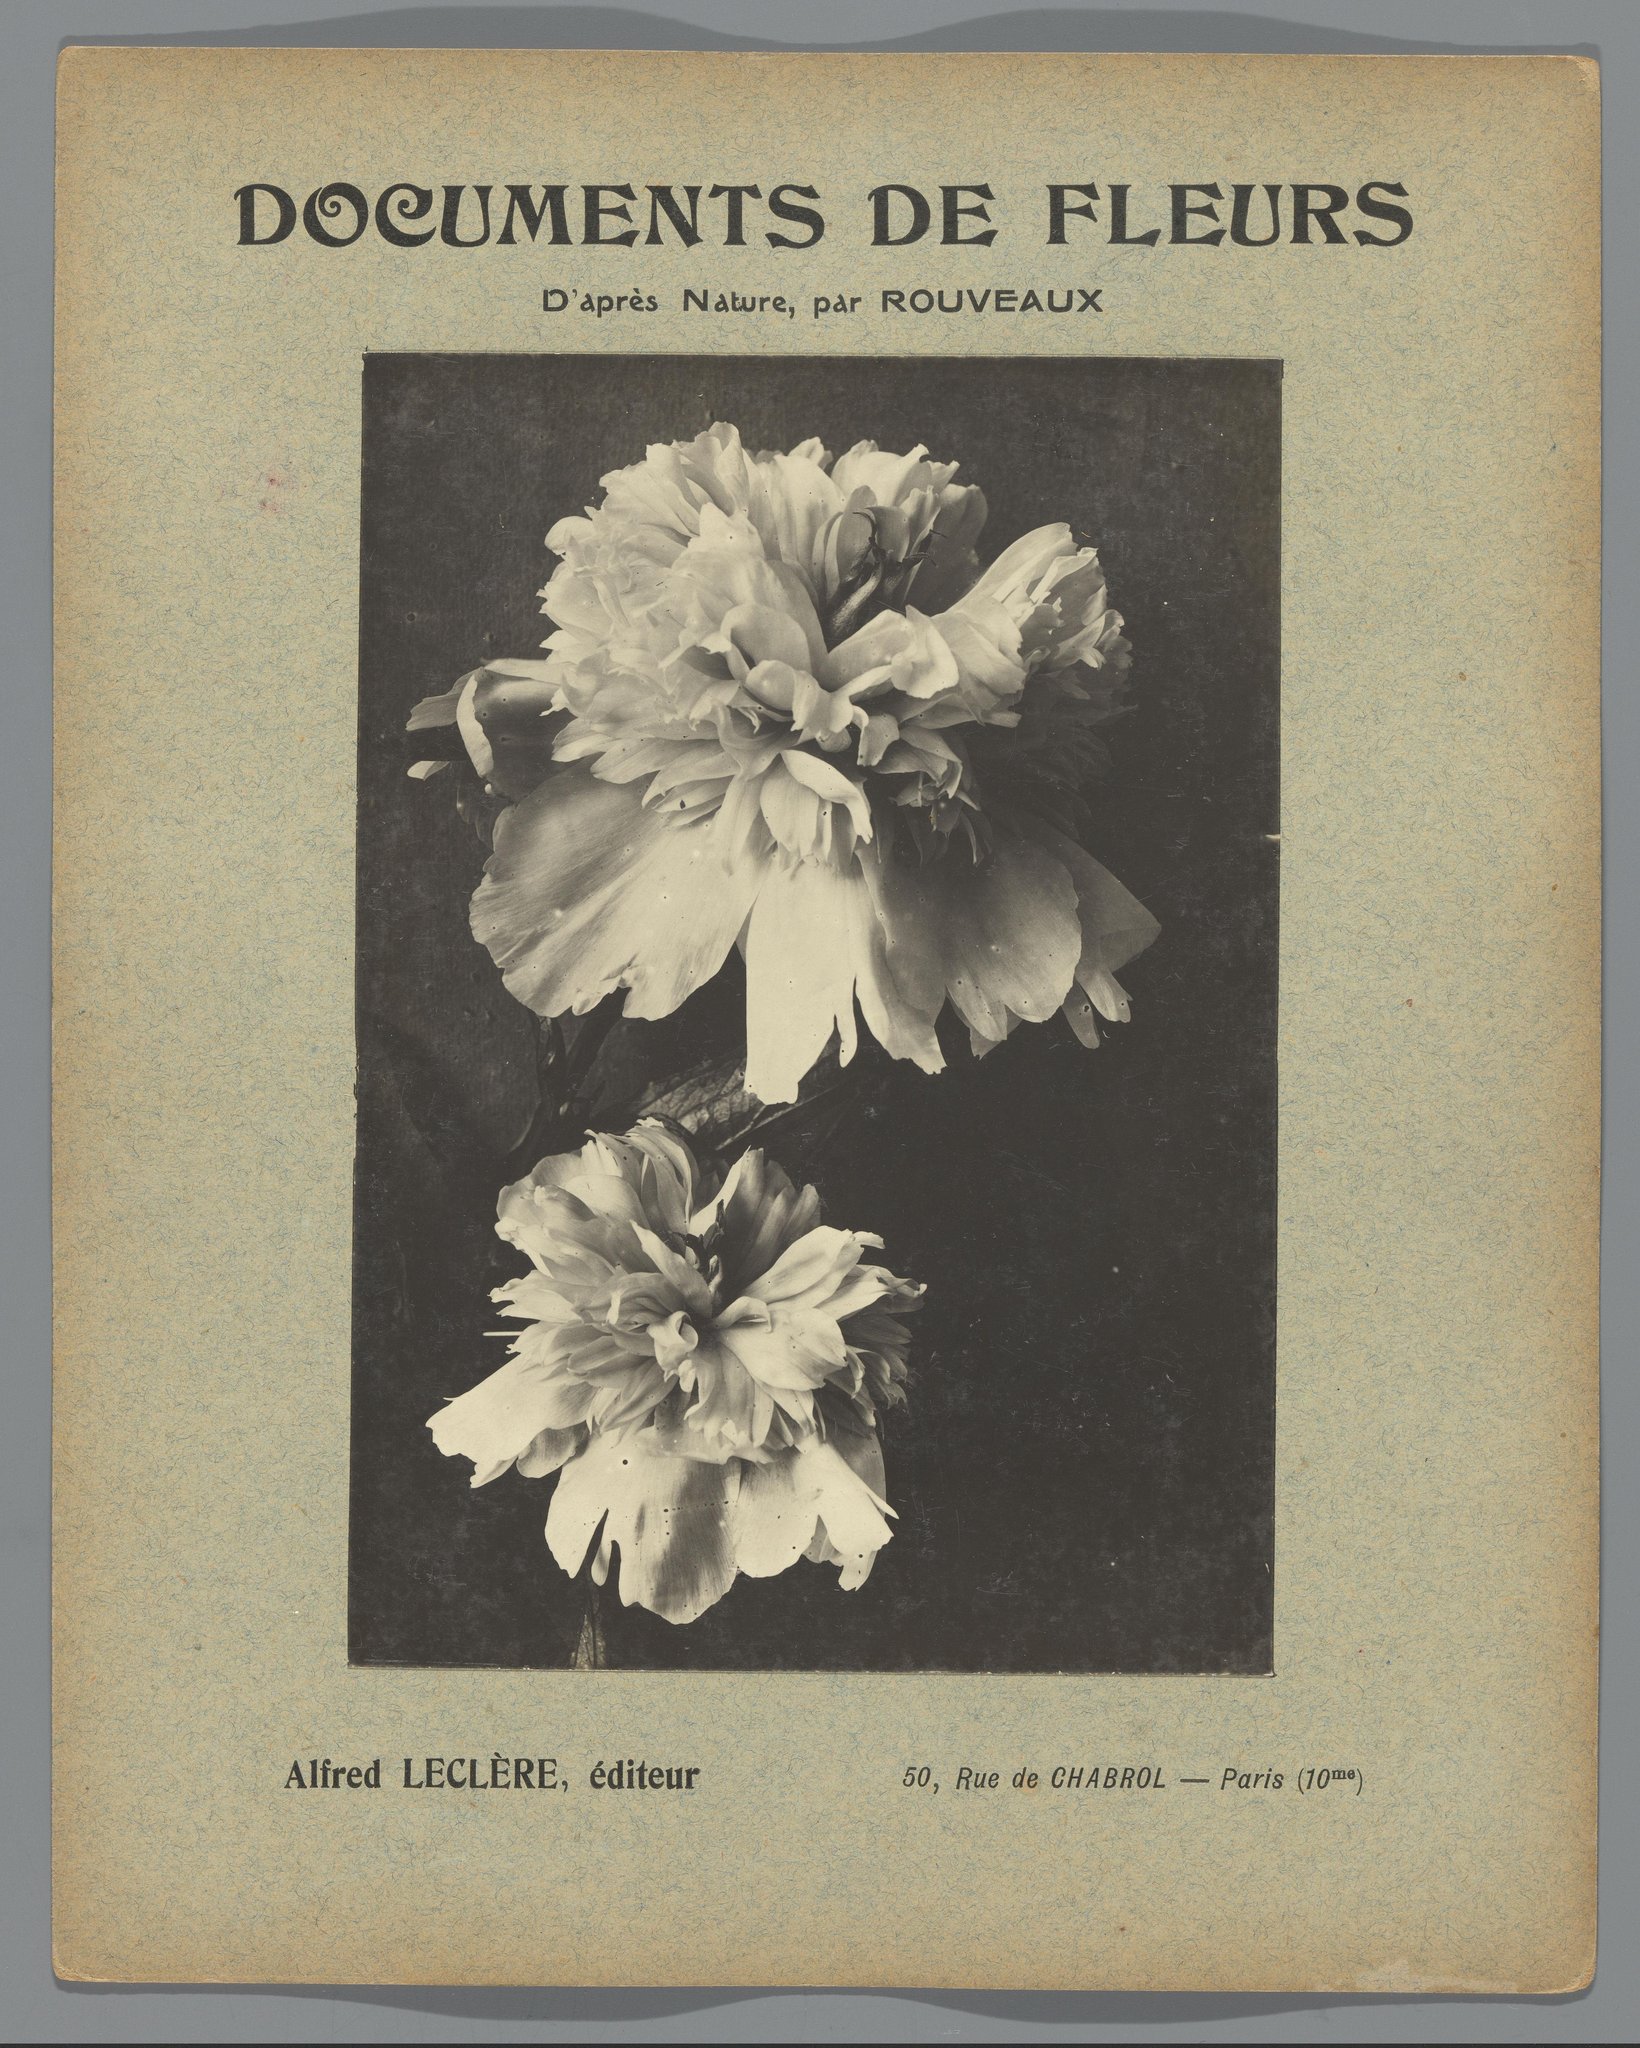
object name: photograph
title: Bloemstudie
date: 1895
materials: photographic support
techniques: gelatin silver print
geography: france